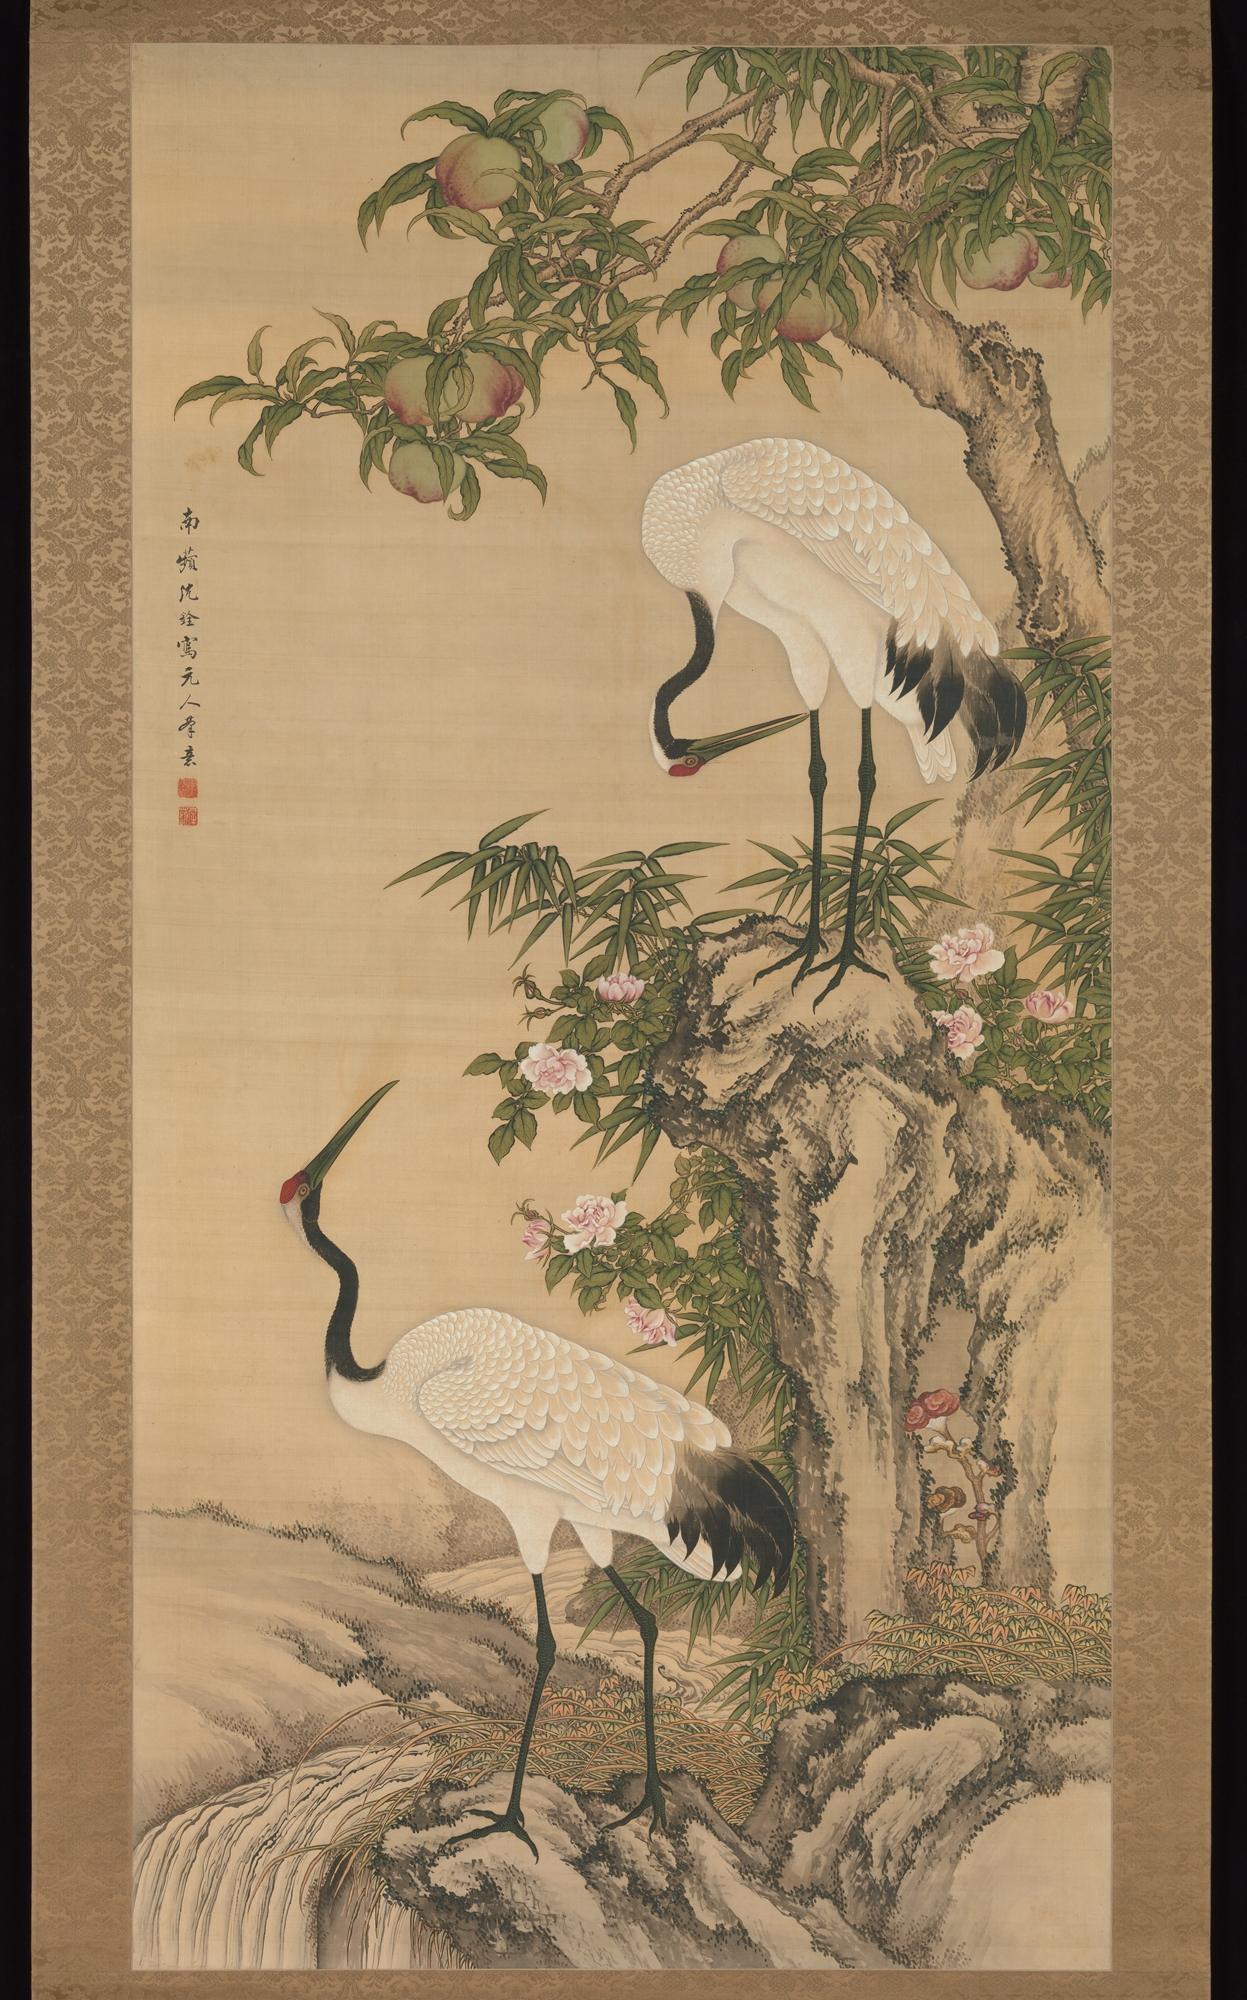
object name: hanging scroll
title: Cranes, peach tree, and China rose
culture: chinese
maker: shen quan (shen pin)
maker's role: artist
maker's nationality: chinese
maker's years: 1682-1762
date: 1701-1800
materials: ink, silk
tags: cranes,peaches,roses,trees